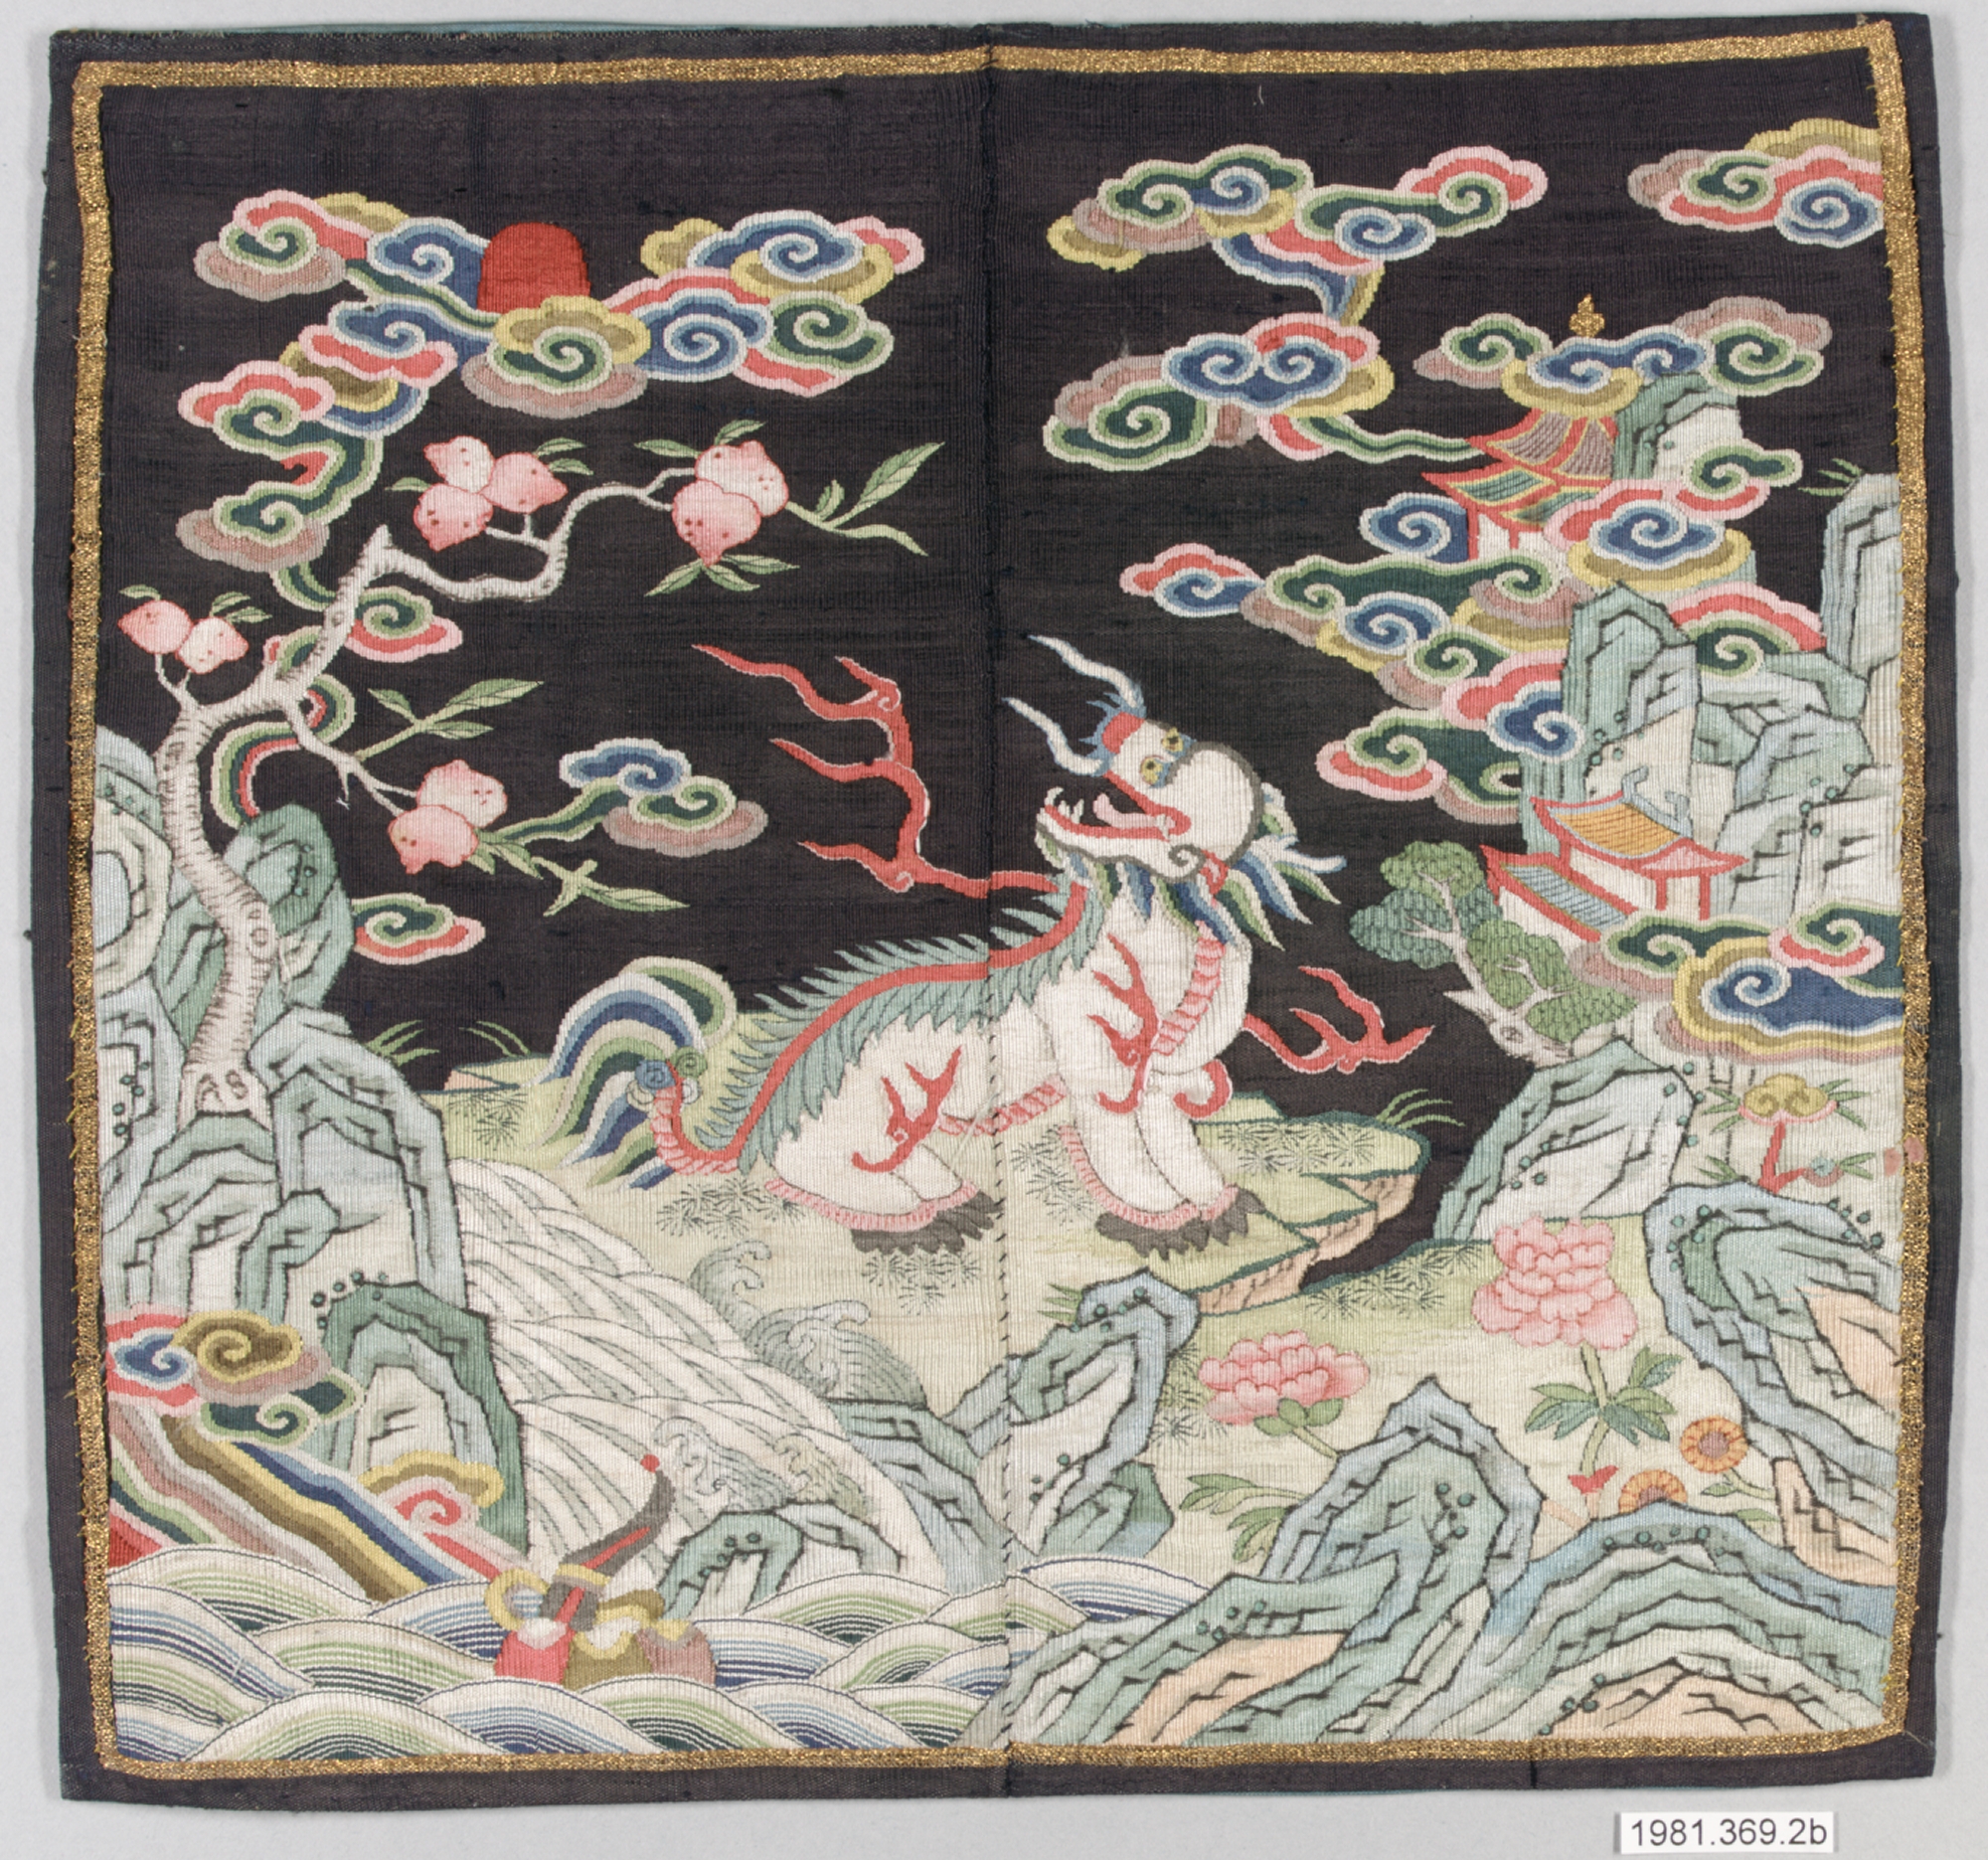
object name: rank badge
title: Rank Badge with Lions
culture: chinese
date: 1701-1800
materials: metal thread, silk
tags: lions